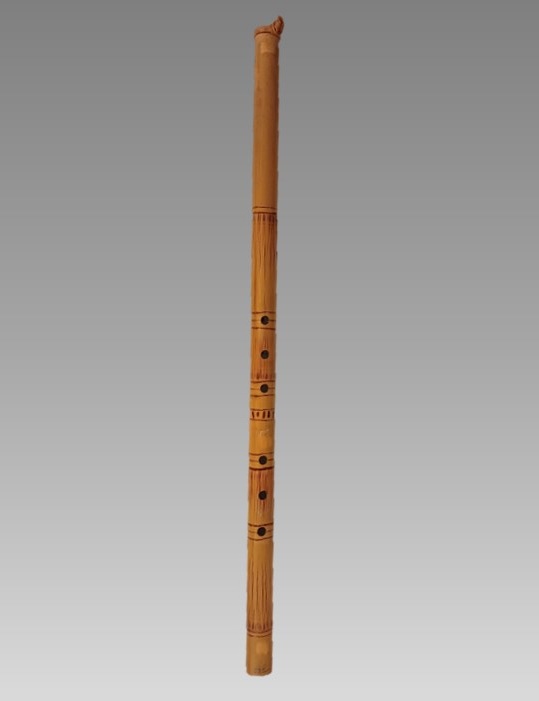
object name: suling pélog ring flute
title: Suling Pélog (ring flute)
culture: javanese, sunda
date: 1801-1900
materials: bamboo, rattan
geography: indonesia